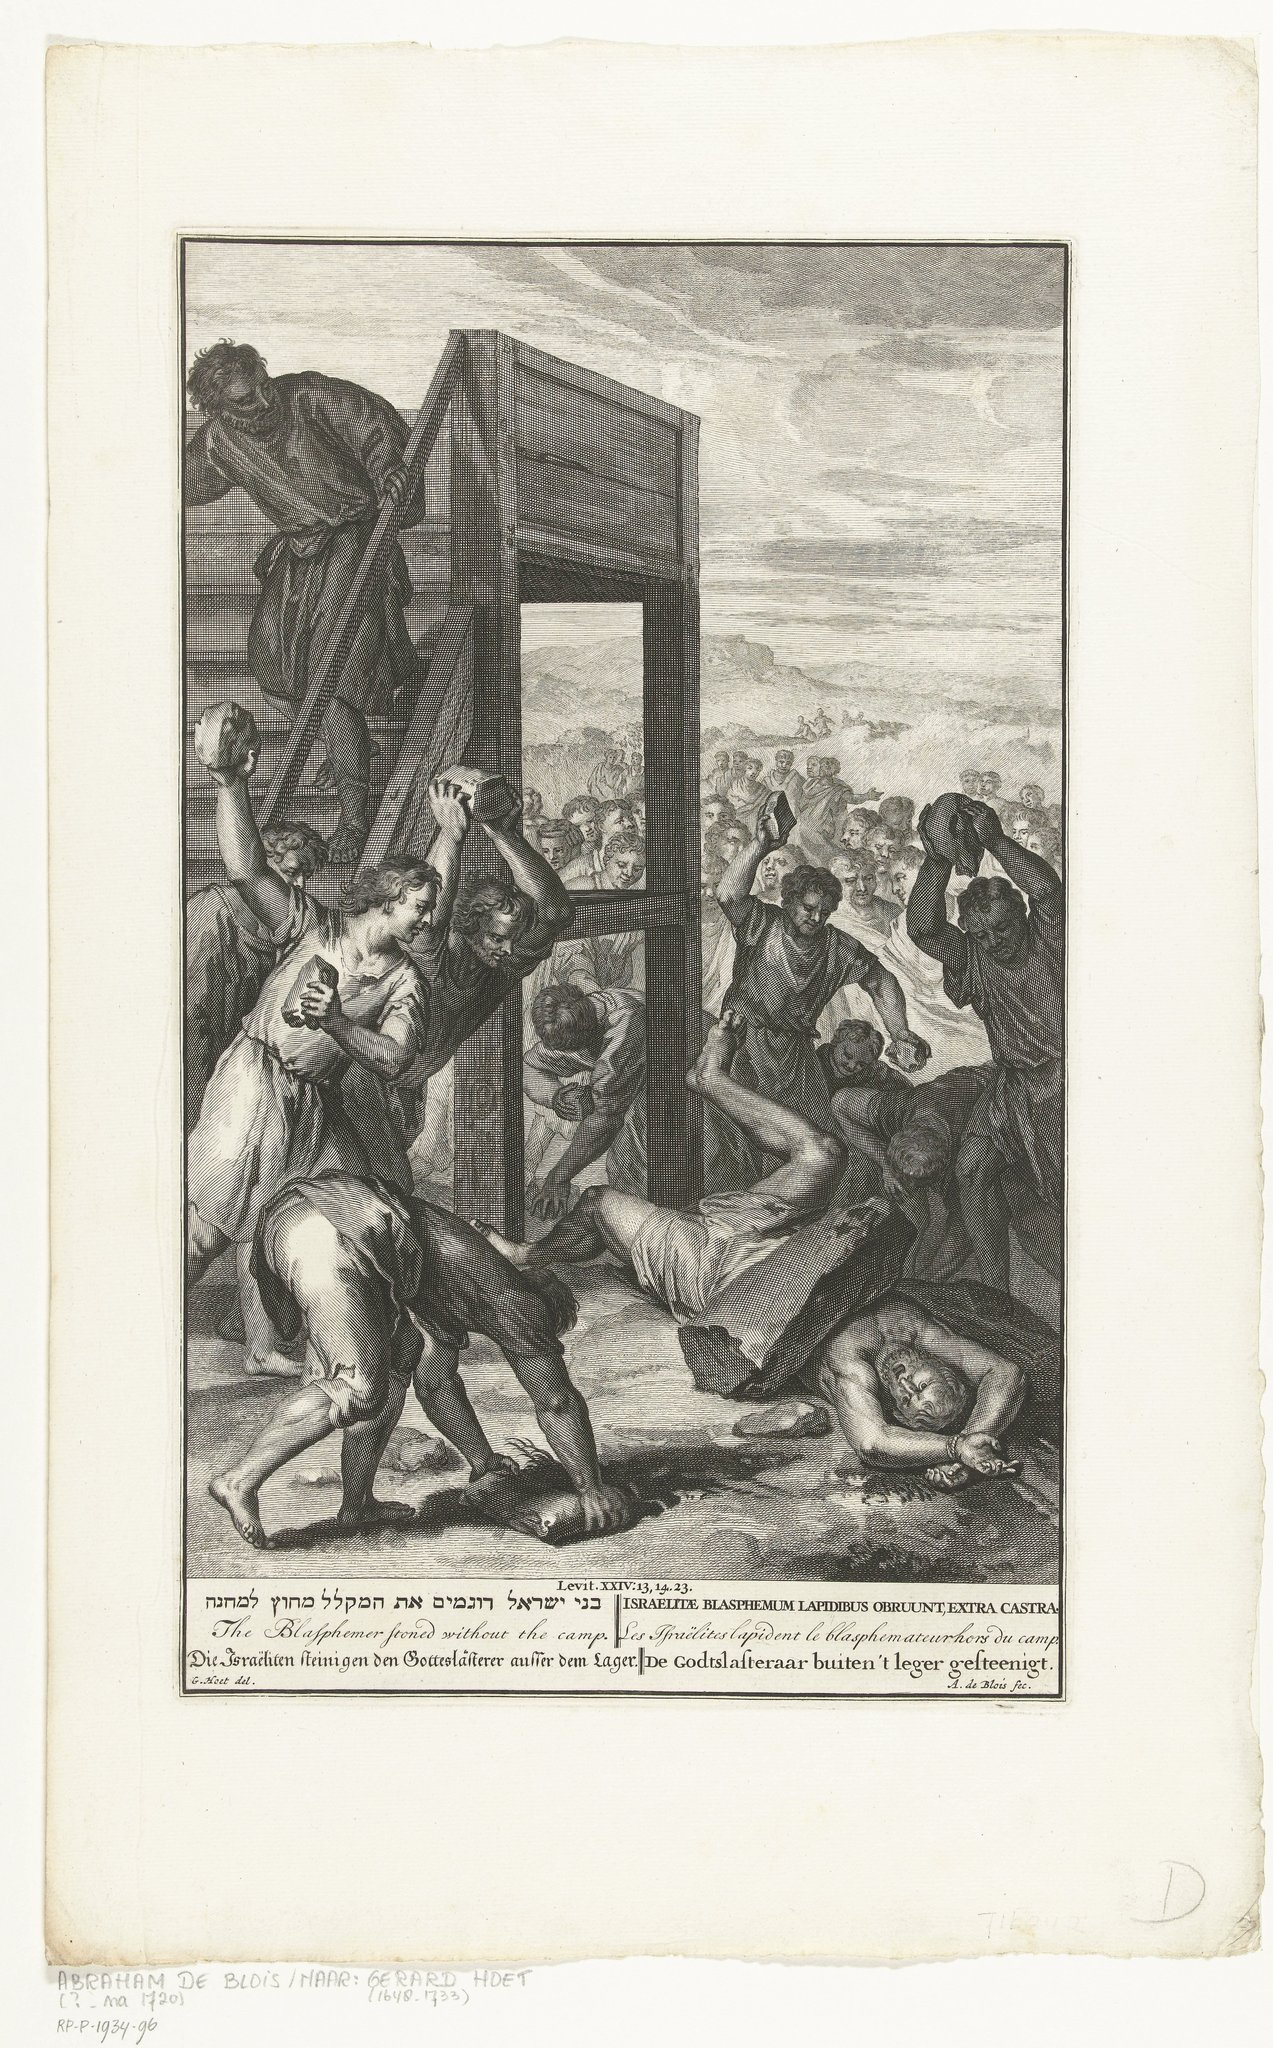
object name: book illustration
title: De Godtslasteraar buiten 't leger gesteenigt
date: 1720-1728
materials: paper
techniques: engraving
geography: amsterdam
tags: violent death by stoning, the son of shelomith is stoned to death by the israelites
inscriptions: collector's mark: Lugt 2228, inscription: ‘utrechts Fundatie huijs’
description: Prent gemaakt voor: Figures de la Bible. Amsterdam, Bernard Picart, 1720. Prent ook gebruikt in: Taferelen der voornaamste geschiedenissen van het Oude en Nieuwe Testament (...) door de vermaarde kunstenaars Hoet, Houbraken, en Picart getekent (...) en met beschrijvingen uitgebreid. Den Haag: Pieter de Hondt, 1728.